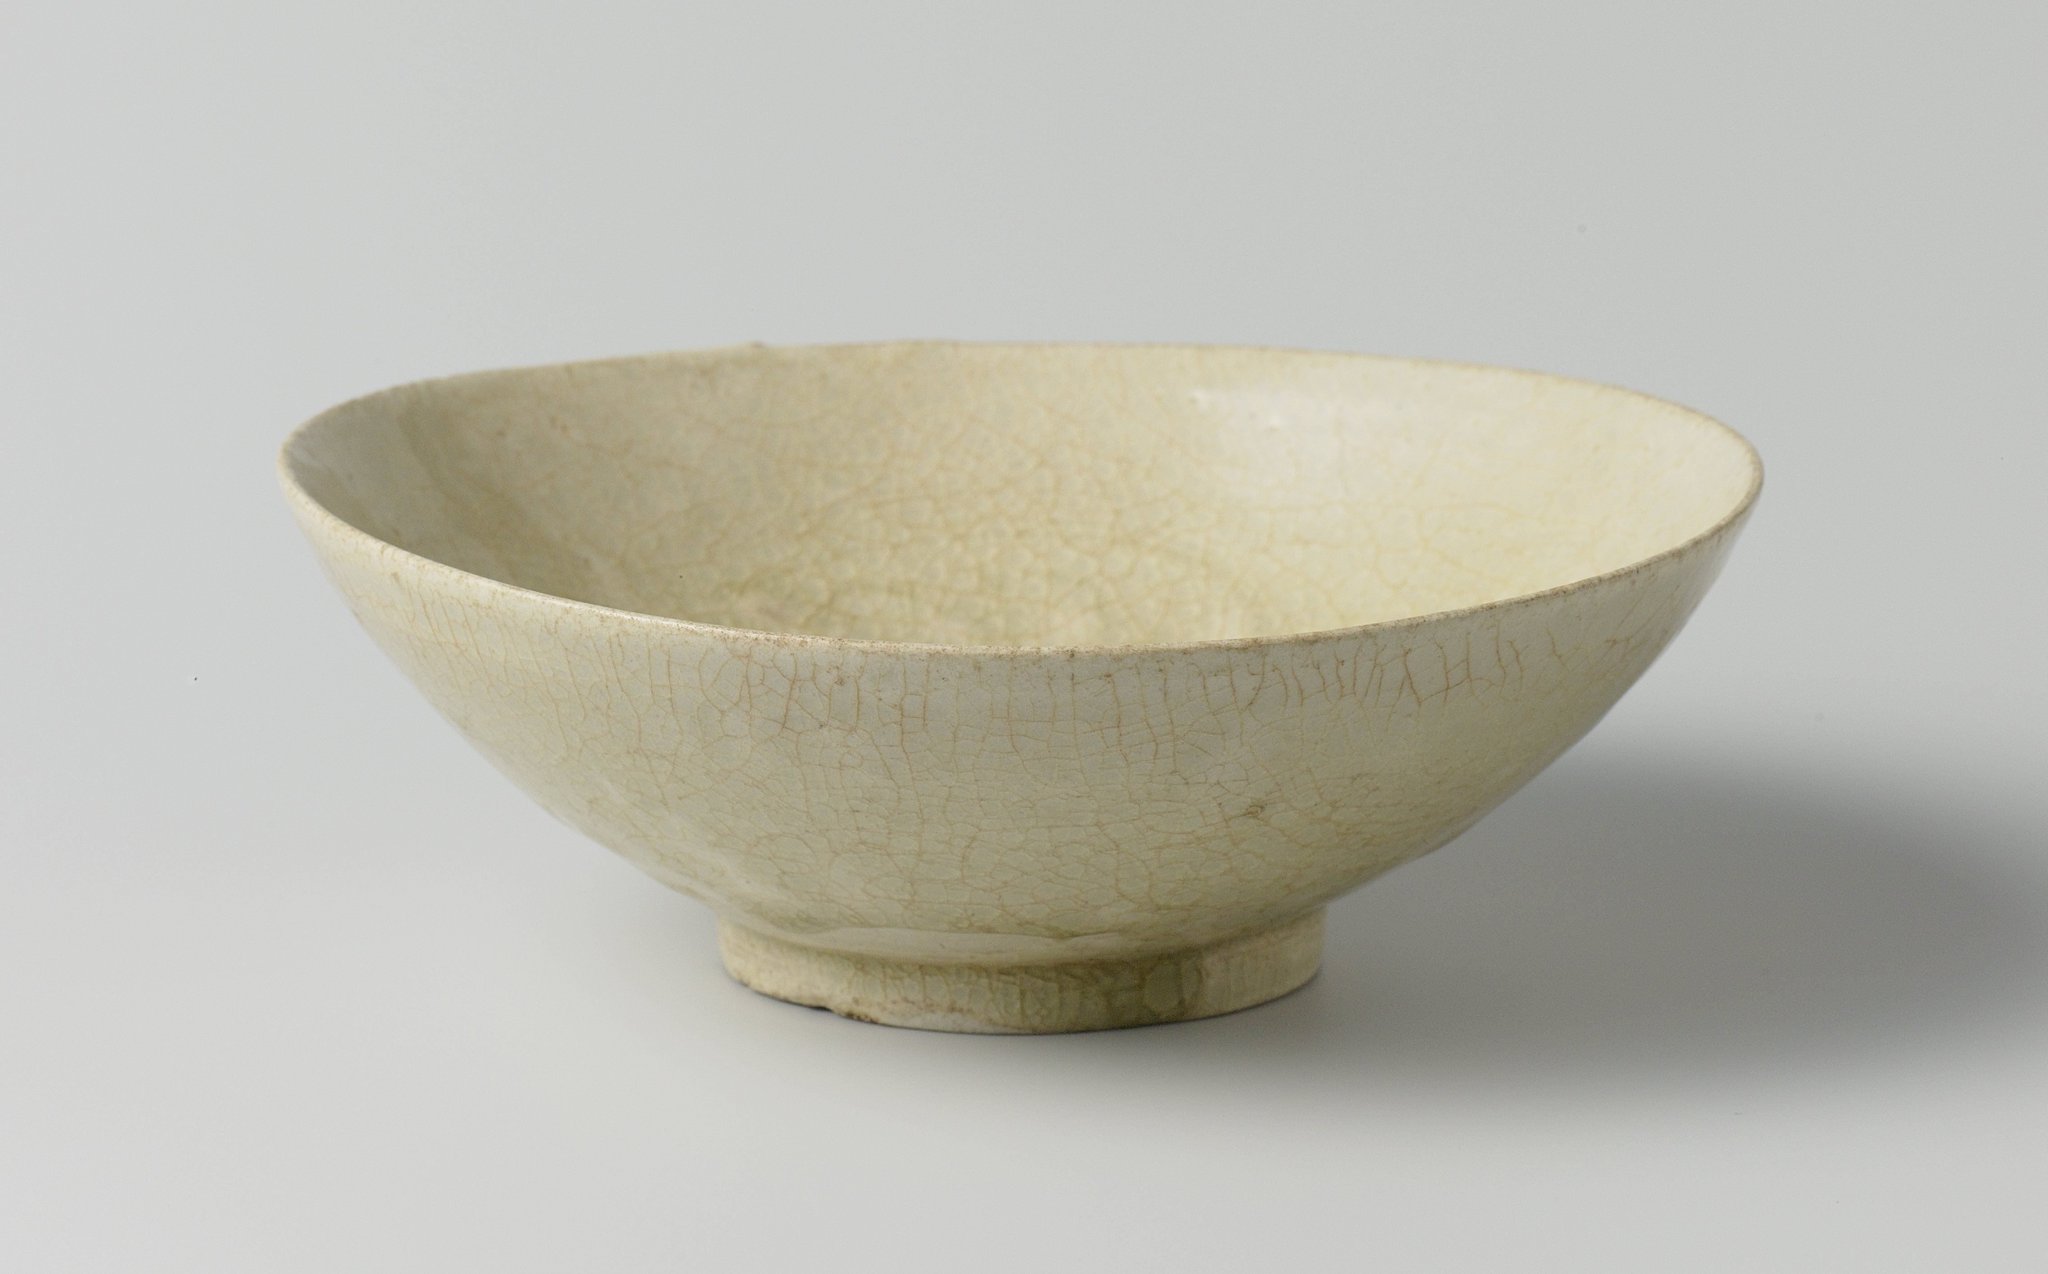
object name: bowl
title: Bowl with a green glaze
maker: Anonymous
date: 1000-1200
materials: earthenware, glaze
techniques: firing, turning, vitrification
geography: vietnam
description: Kom van aardewerk, bedekt met een groen, gecraqueleerd glazuur.